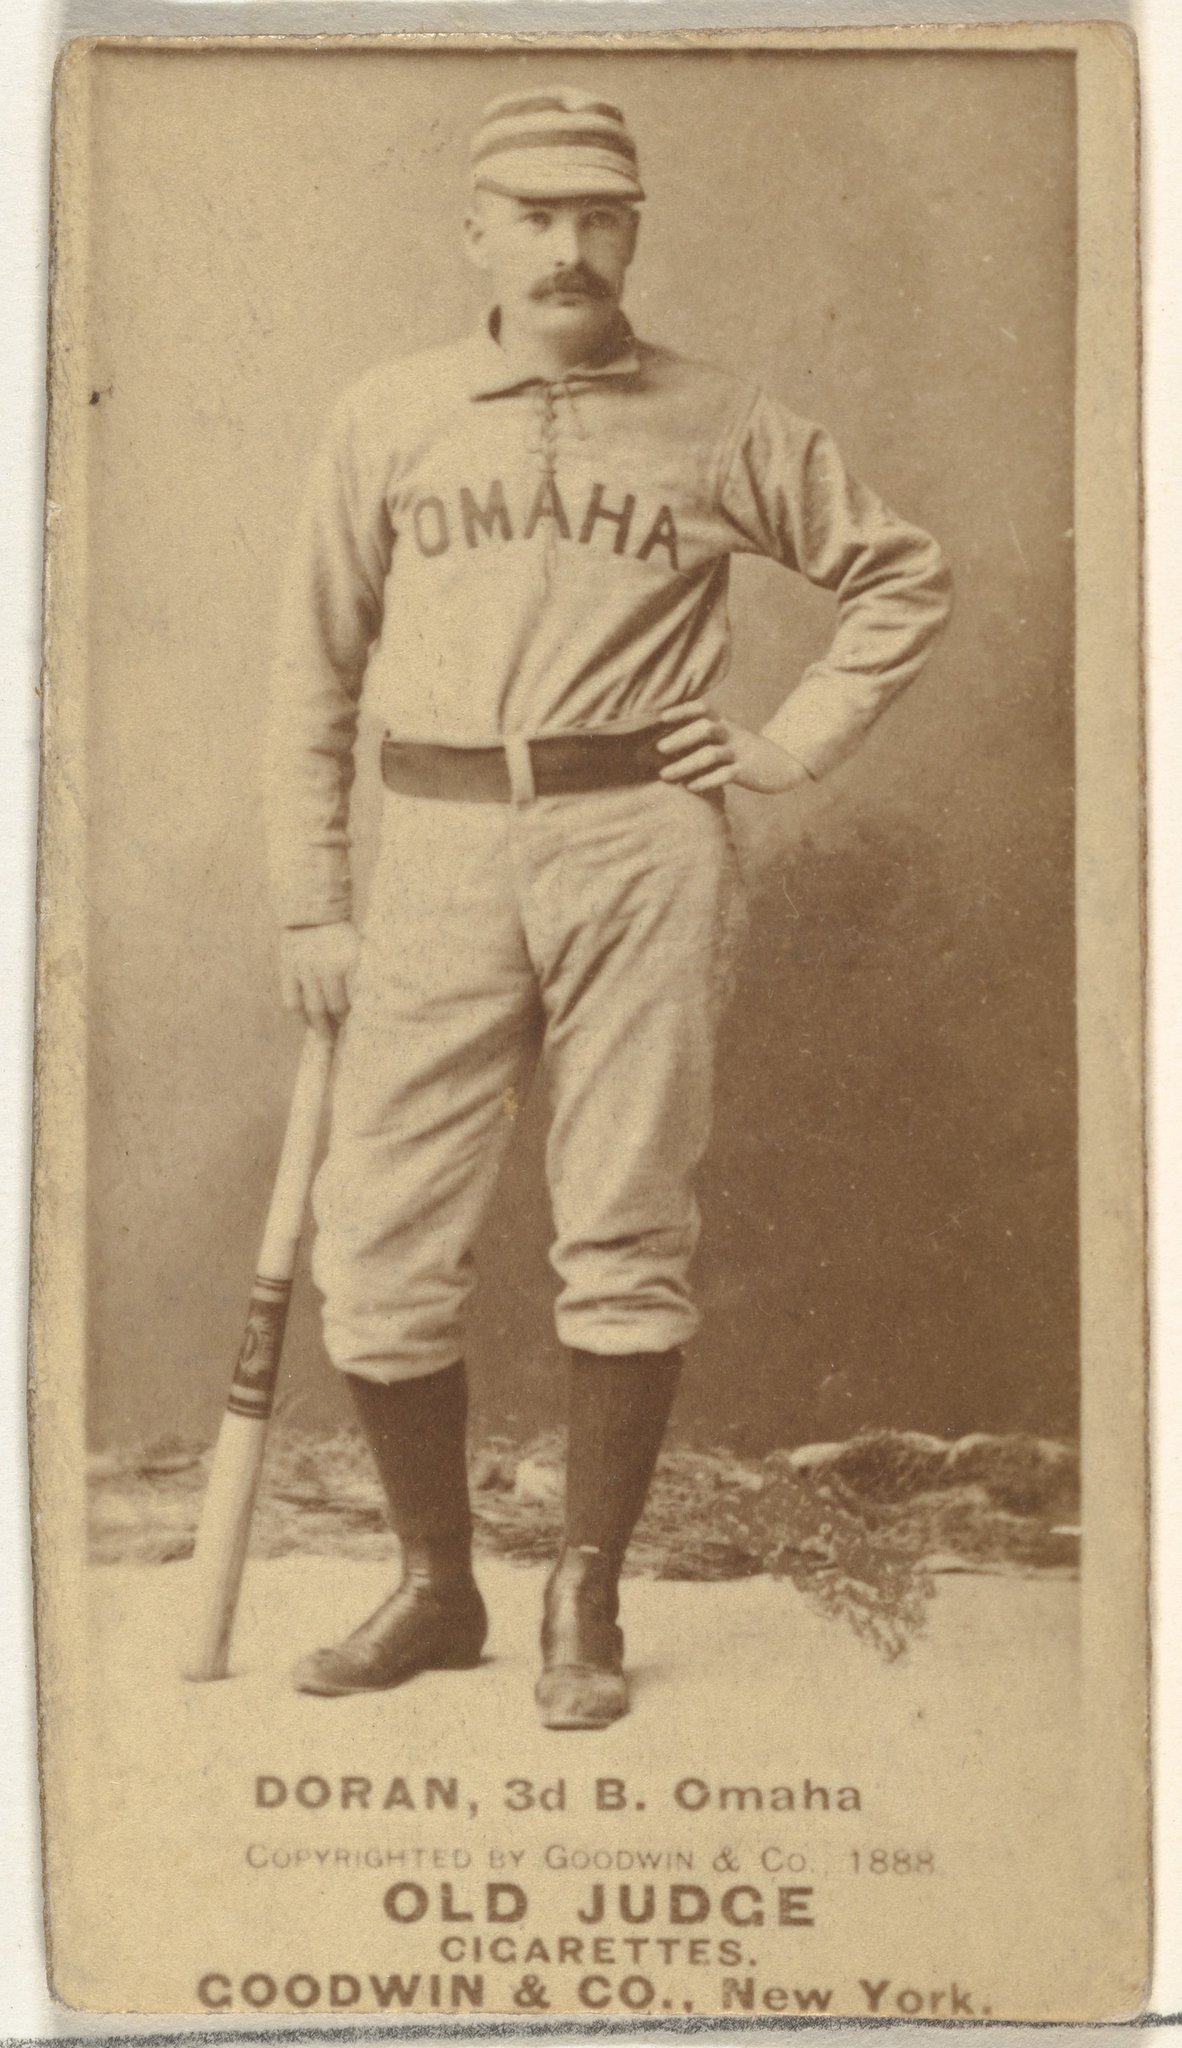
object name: baseball card, photograph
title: Doran, 3rd Base, Omaha Omahogs/ Lambs, from the Old Judge series (N172) for Old Judge Cigarettes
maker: goodwin & company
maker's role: publisher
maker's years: 1850-1950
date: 1888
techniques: albumen silver print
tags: men,portraits,baseball,athletes